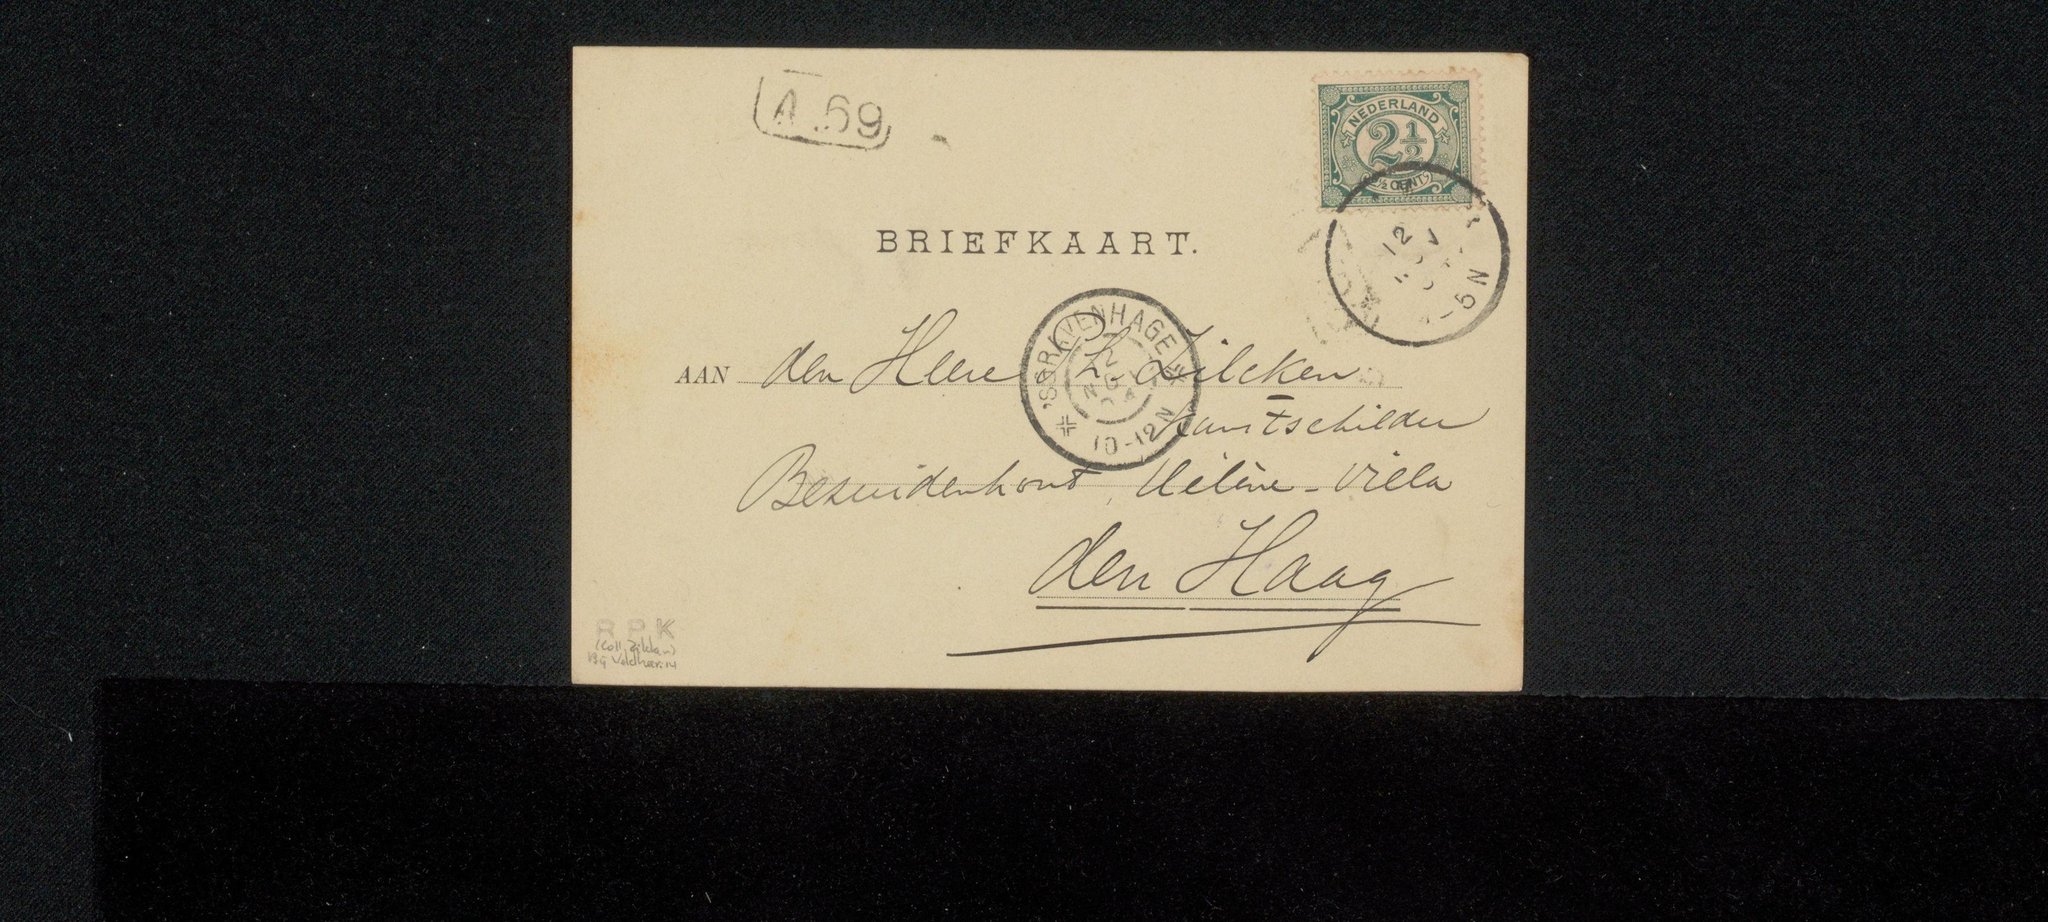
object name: postcard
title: Briefkaart aan Philip Zilcken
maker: jacobus gerardus veldheer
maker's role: draughtsman, print maker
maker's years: 1866-1954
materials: cardboard, ink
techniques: pen, writing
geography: bergen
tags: the hague, painter, draughtsman, philip zilcken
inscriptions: collector's mark: ‘RPK’